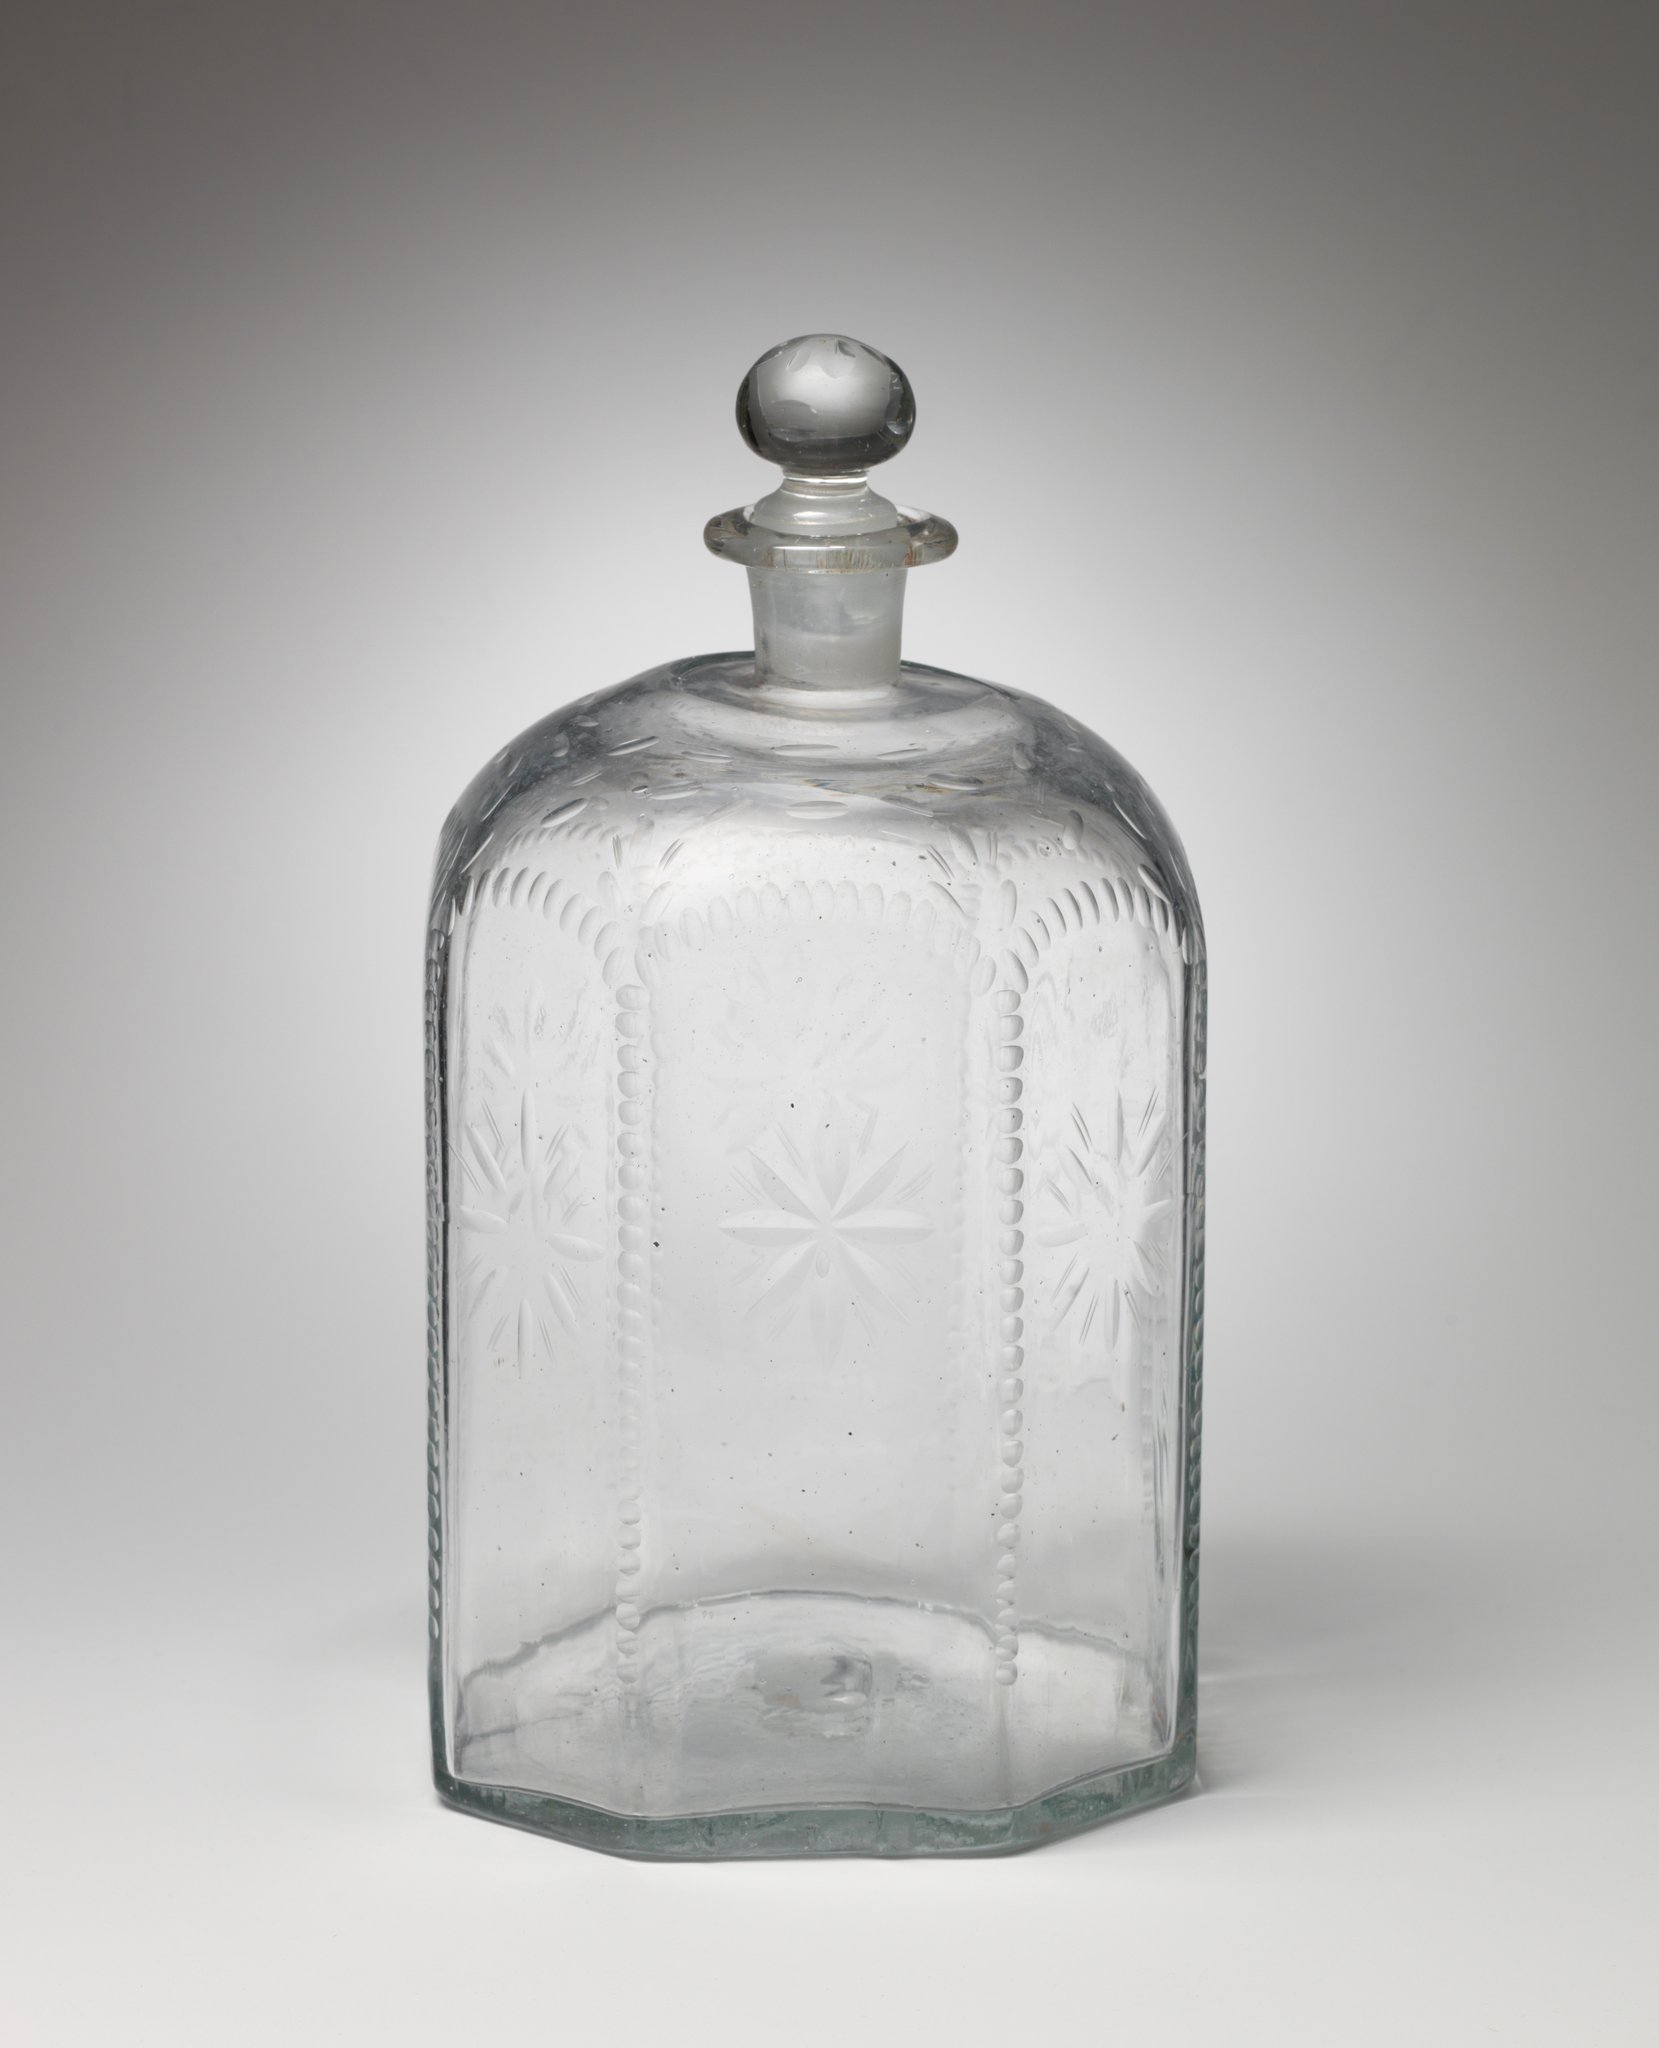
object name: bottle with stopper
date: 1767-1800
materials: glass